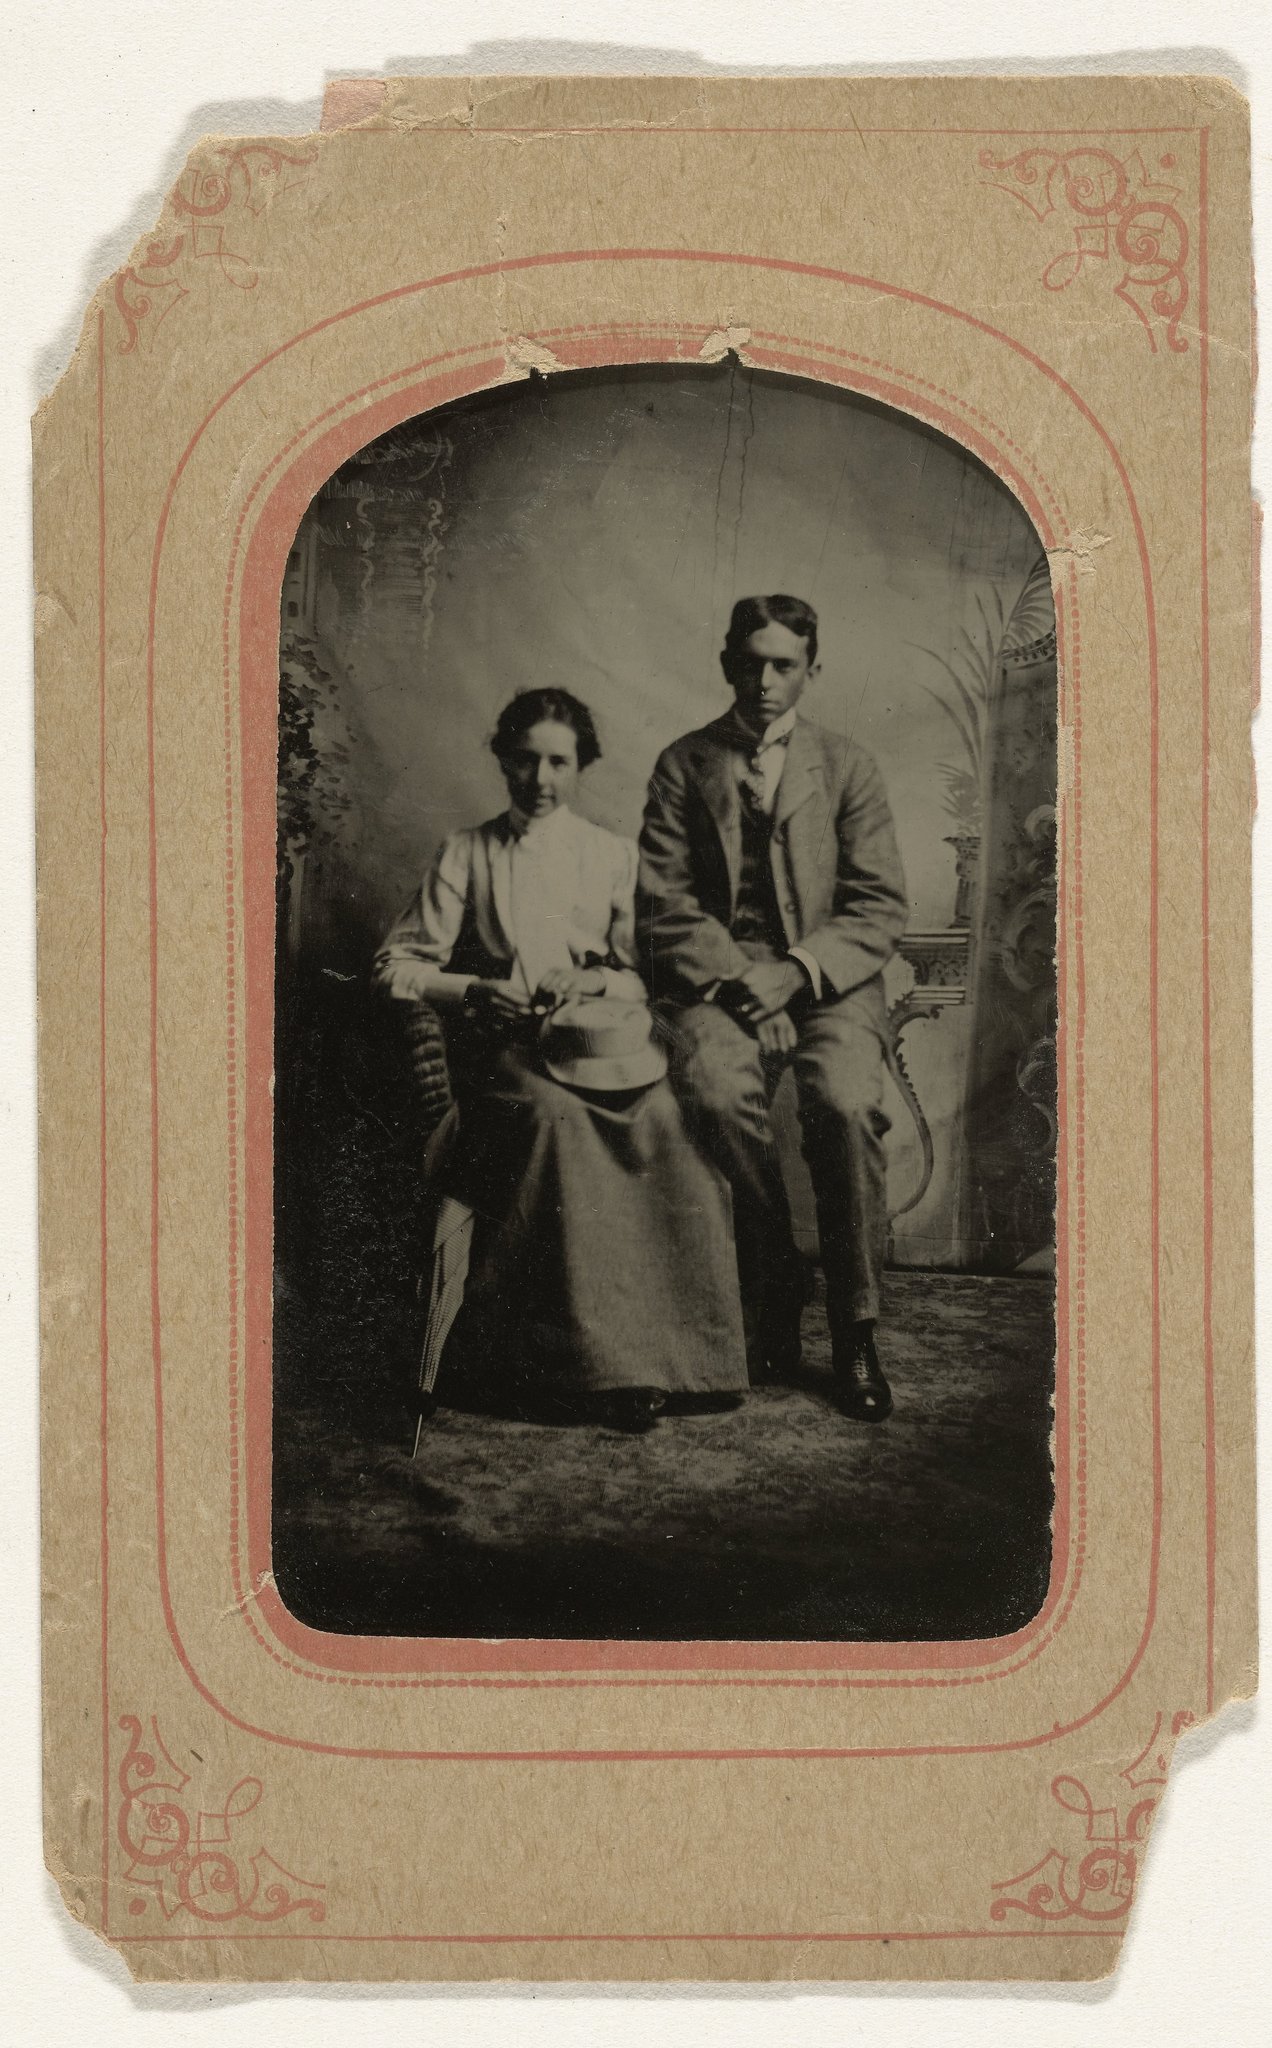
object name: photograph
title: Portret van een man en vrouw, Adirondack Mountains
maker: Anonymous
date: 1898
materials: metal, paper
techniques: ferrotyping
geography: united states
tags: adirondack mountains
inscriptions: annotation: ‘Adirondack Mts / Summer 1898.’